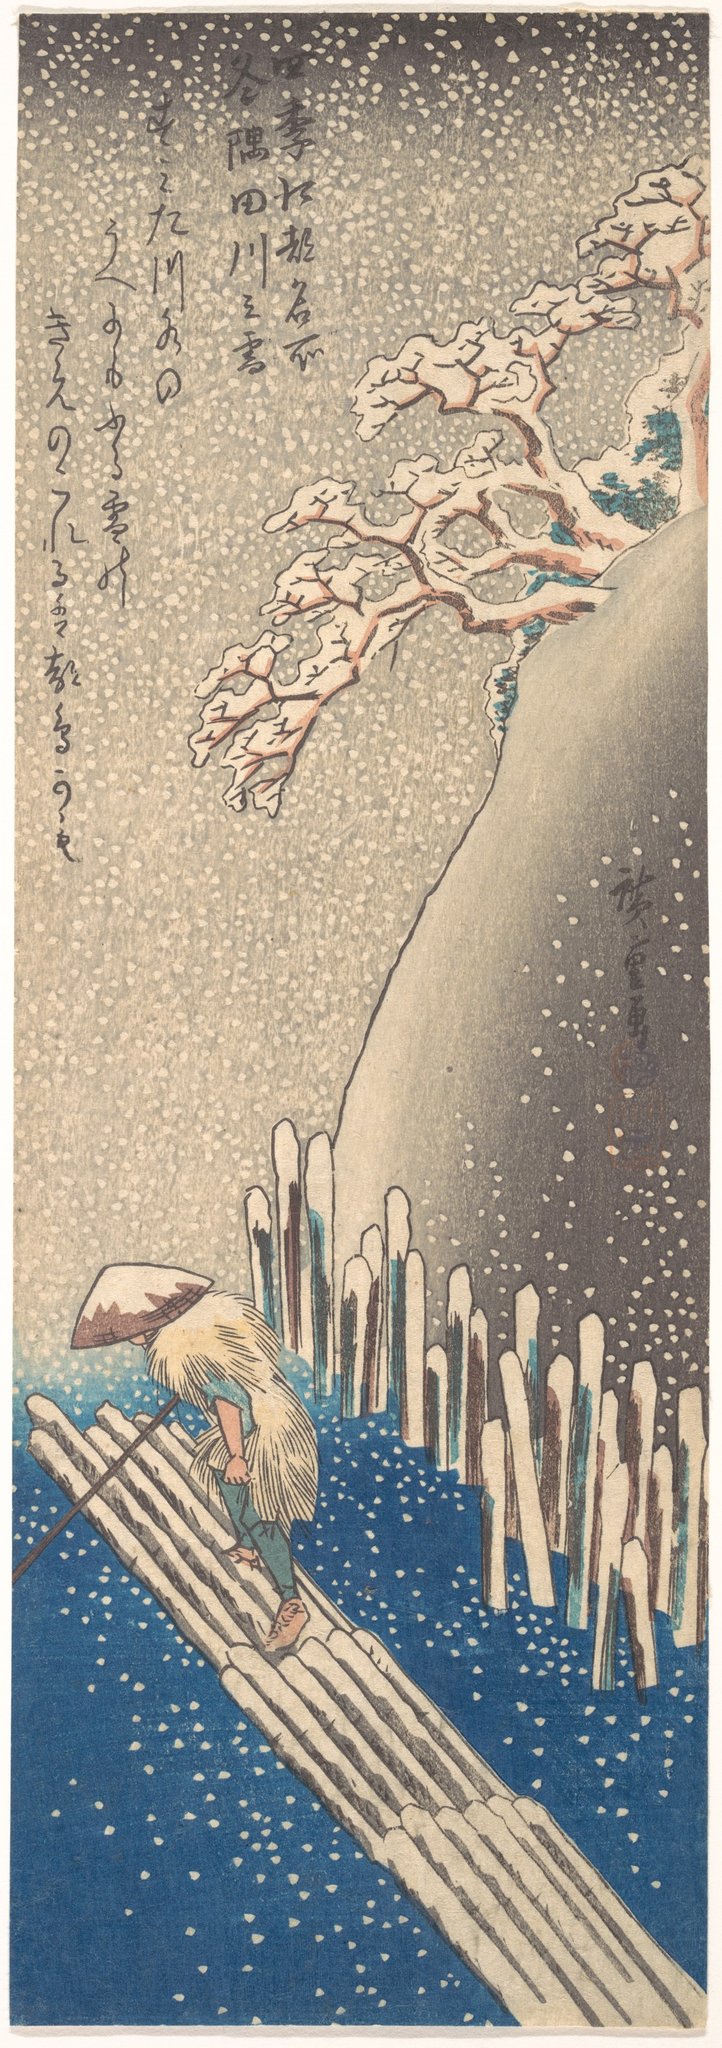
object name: print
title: Sumida River in the Snow, from the series "Famous Places in Edo in the Four Seasons"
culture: japanese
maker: utagawa hiroshige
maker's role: artist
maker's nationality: japanese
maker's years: 1797-1858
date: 1834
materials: ink, paper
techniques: woodblock print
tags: men,rivers,trees,snow